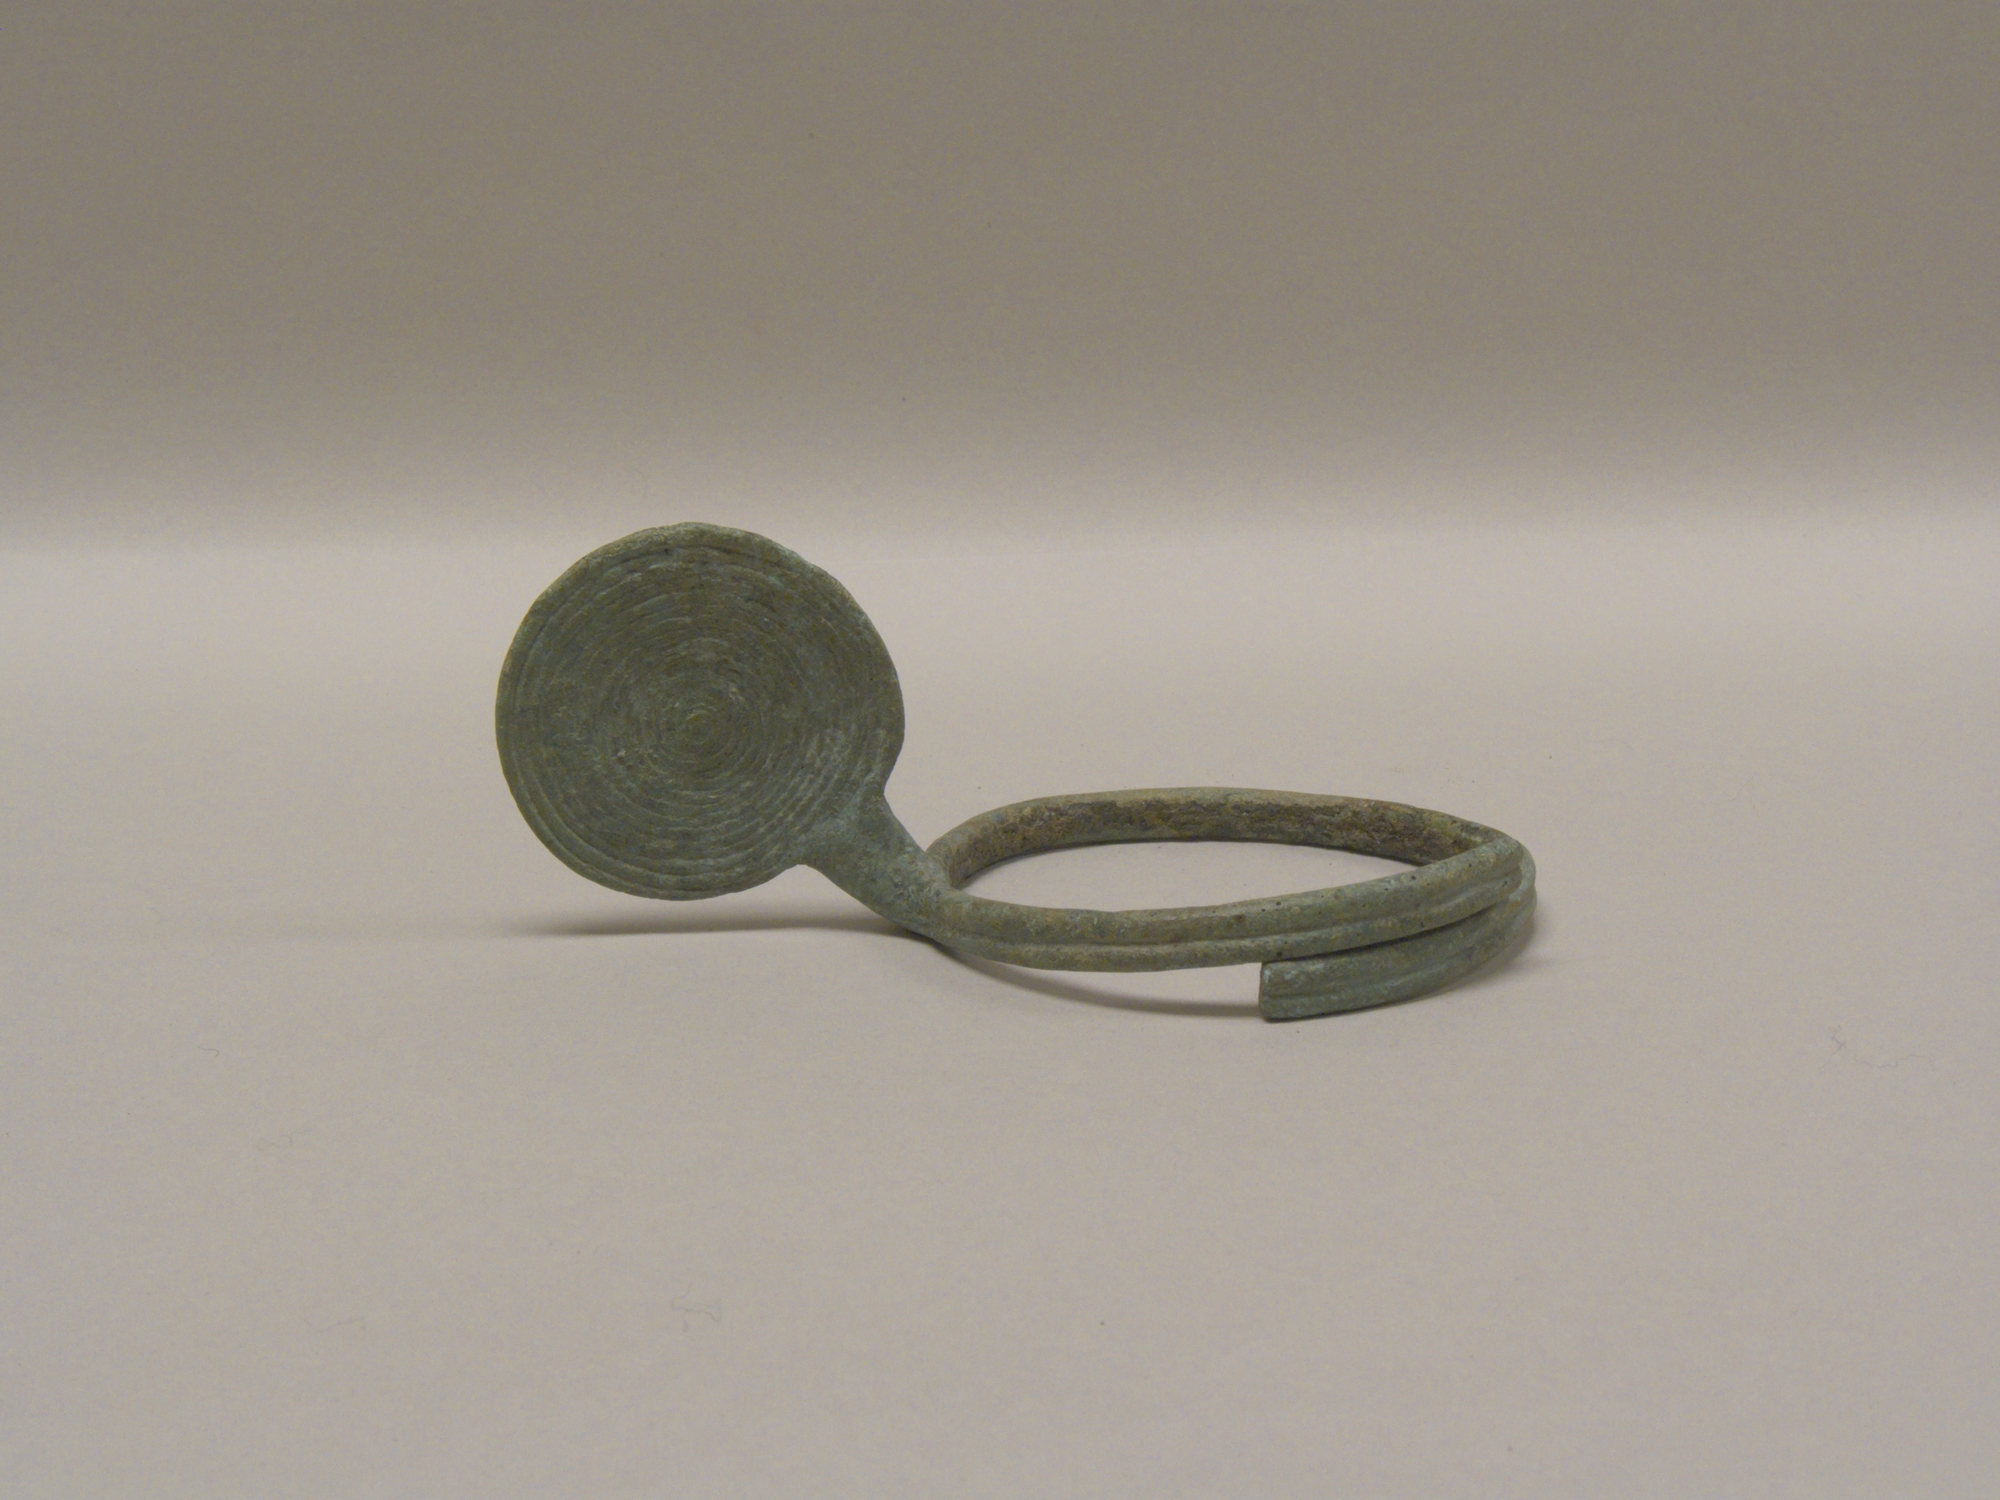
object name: anklet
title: Anklet with Large Spiral Attachment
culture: thai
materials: bronze